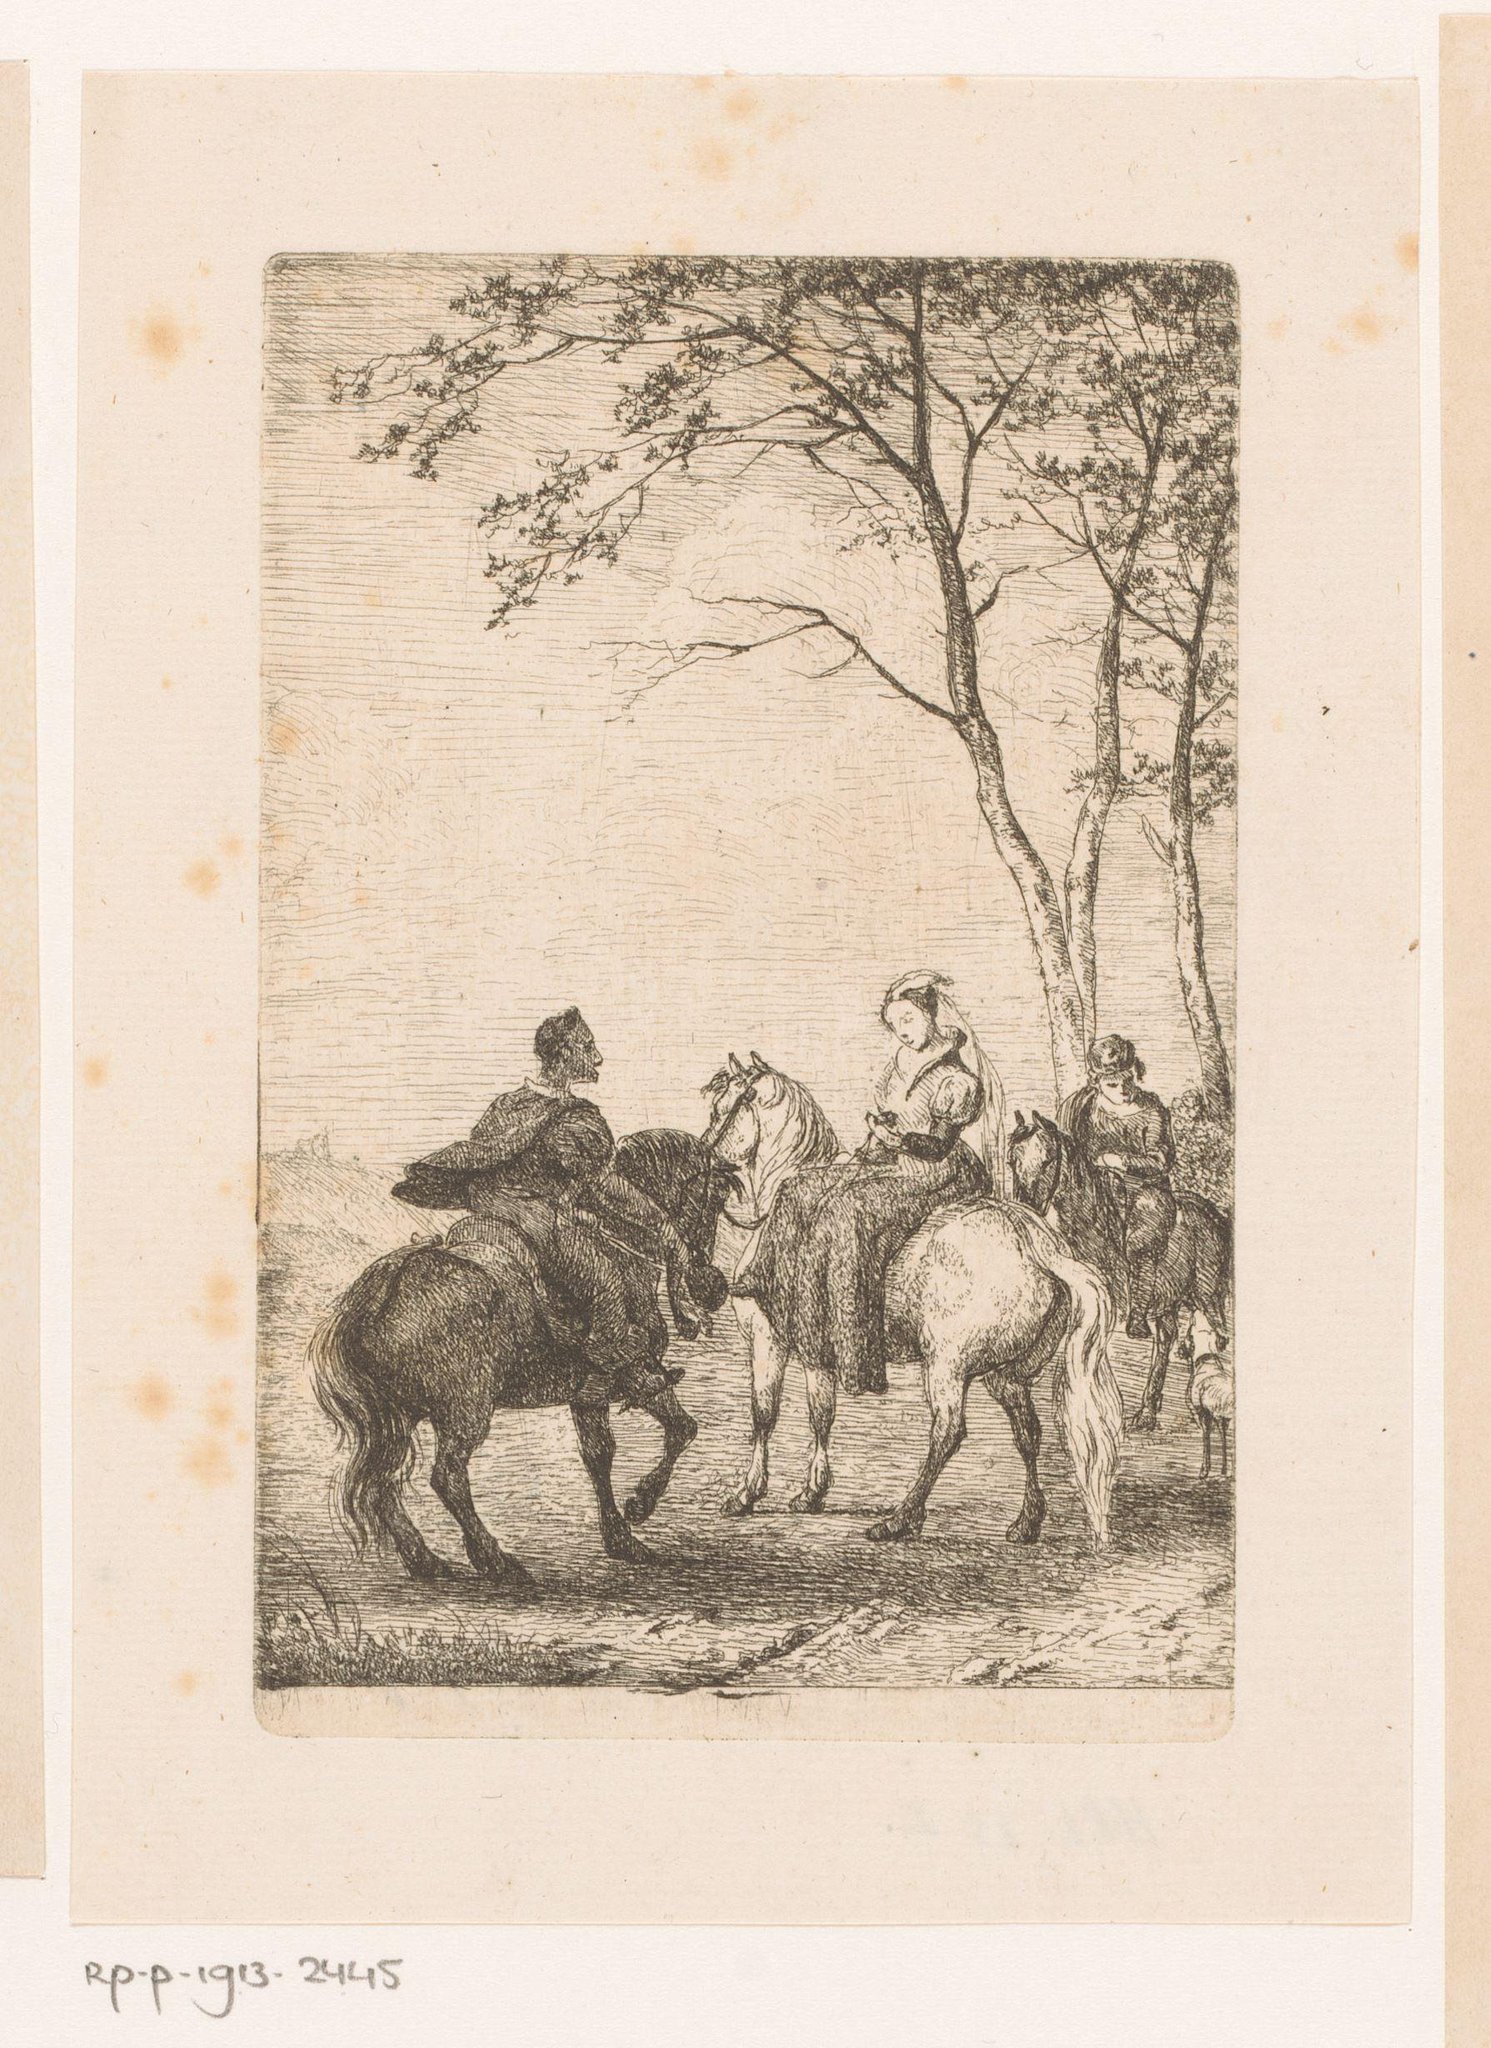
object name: print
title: Ontmoeting in het bos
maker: hendrik jozef franciscus van der poorten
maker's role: draughtsman, print maker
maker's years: 1789-1874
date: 1799-1874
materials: paper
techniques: etching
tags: riding a horse, ass, or mule; rider, horseman, lovers' meeting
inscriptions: collector's mark: Lugt 2228